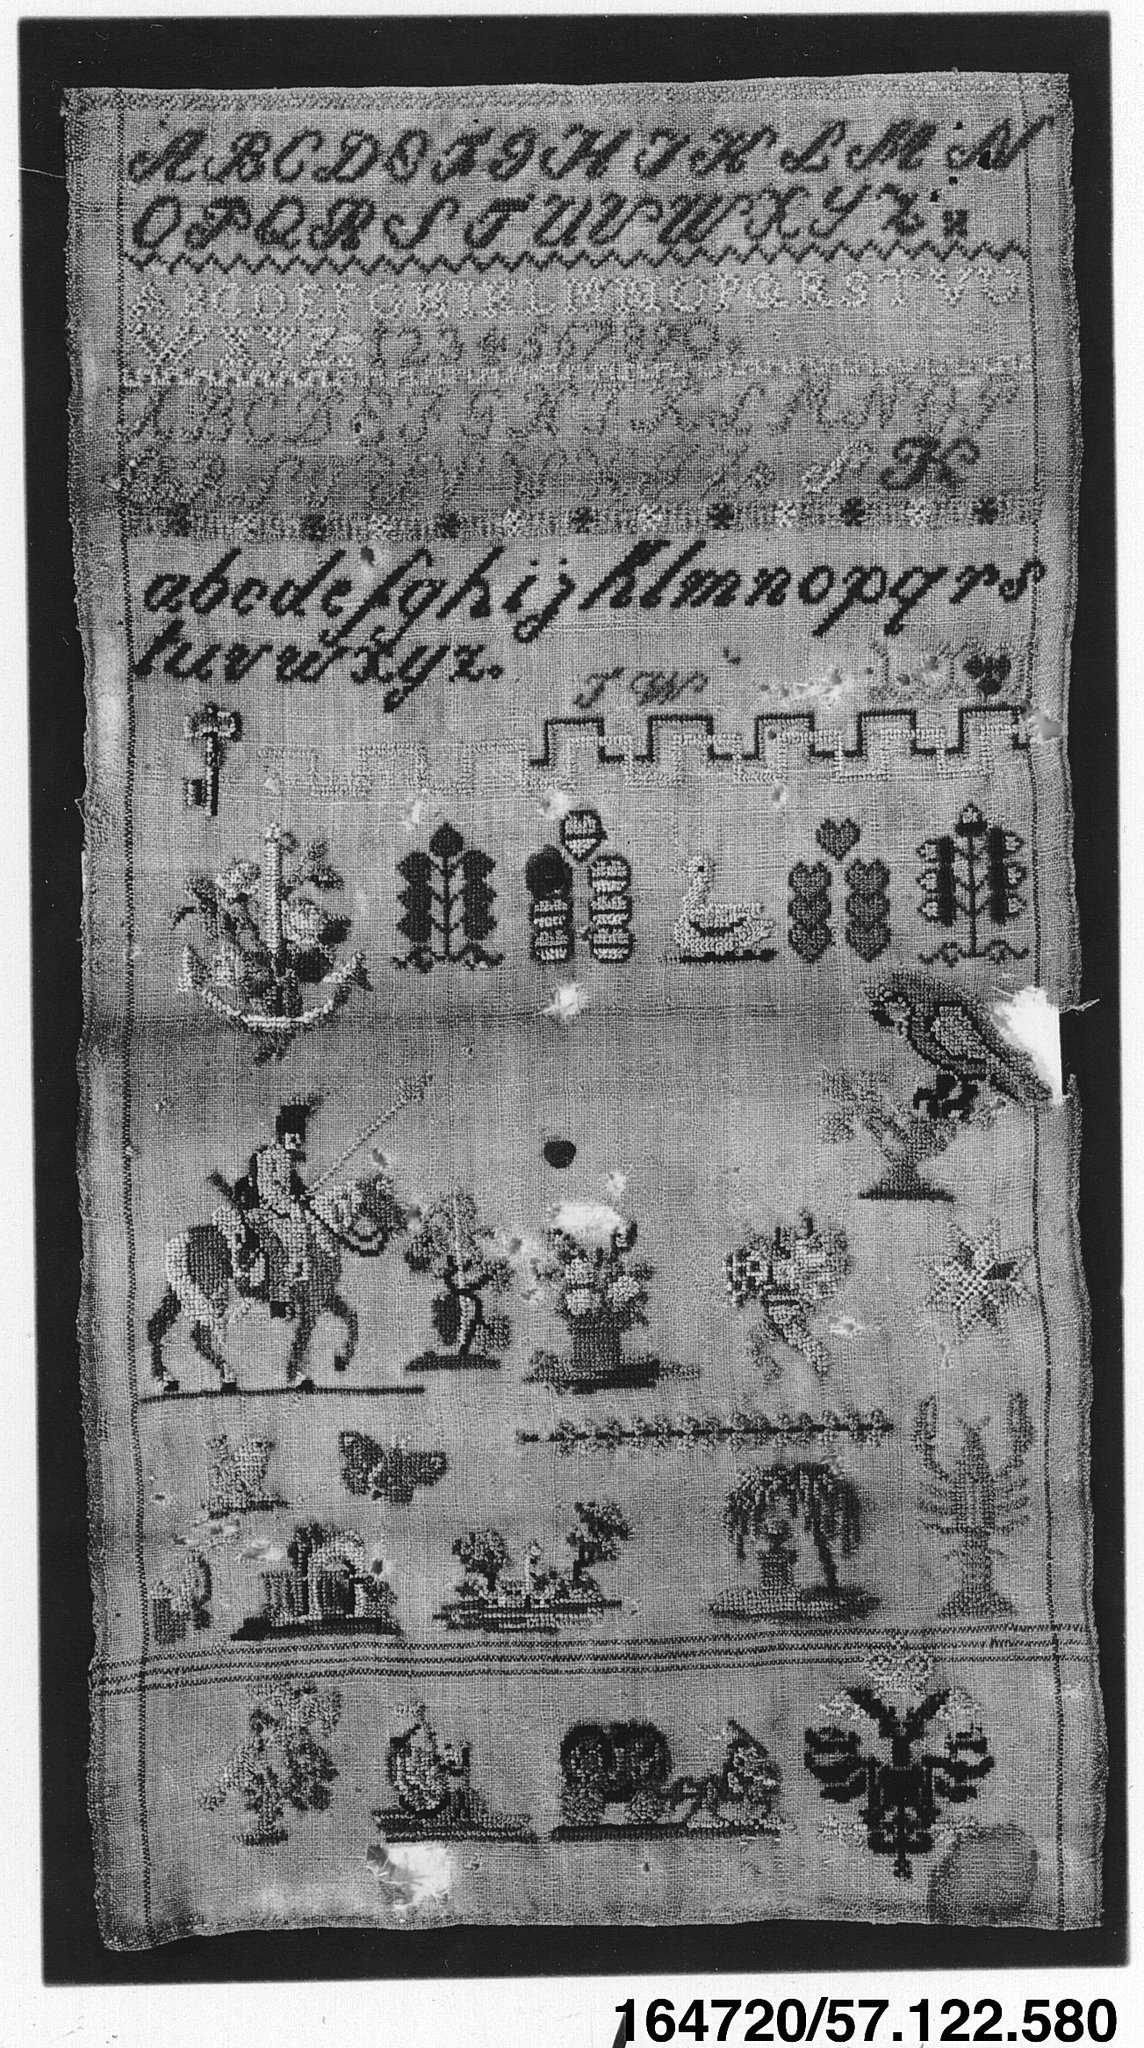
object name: sampler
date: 1801-1900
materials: canvas, silk, wool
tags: animals,birds,horses